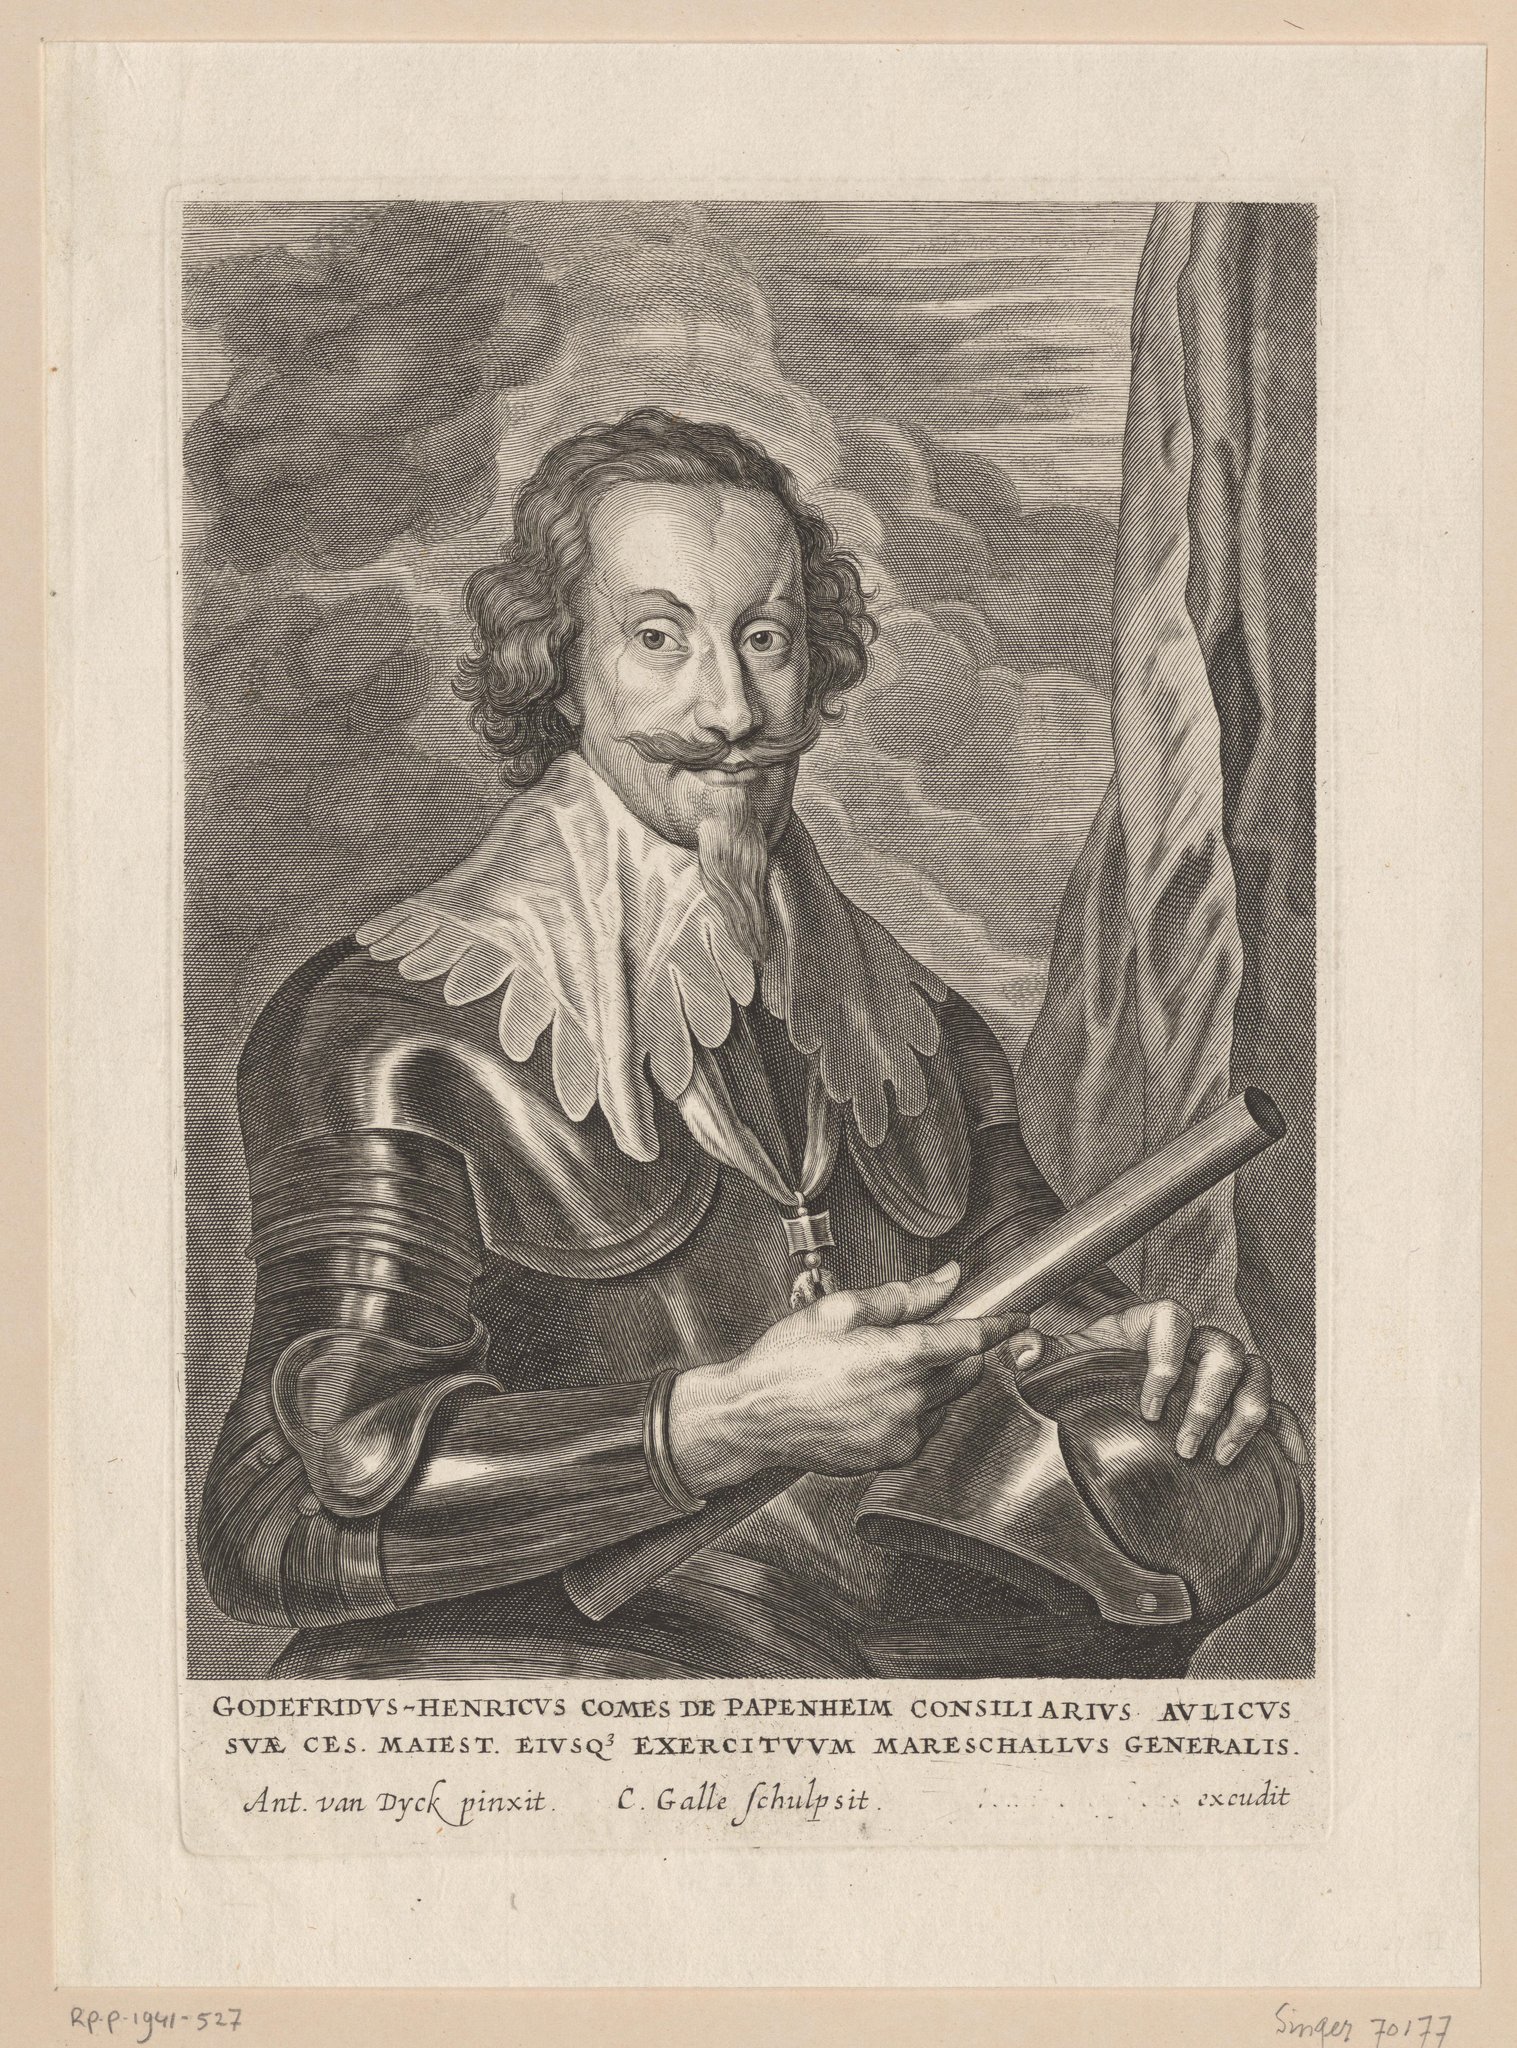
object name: print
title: Portret van Gottfried Heinrich, graaf van Pappenheim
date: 1670-1719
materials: paper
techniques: engraving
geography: antwerp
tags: adult man, historical persons, military clothing and other equipment (uniforms, cap, armour, helmet, etc.)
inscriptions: collector's mark: Lugt 2760, collector's mark: Lugt 2228